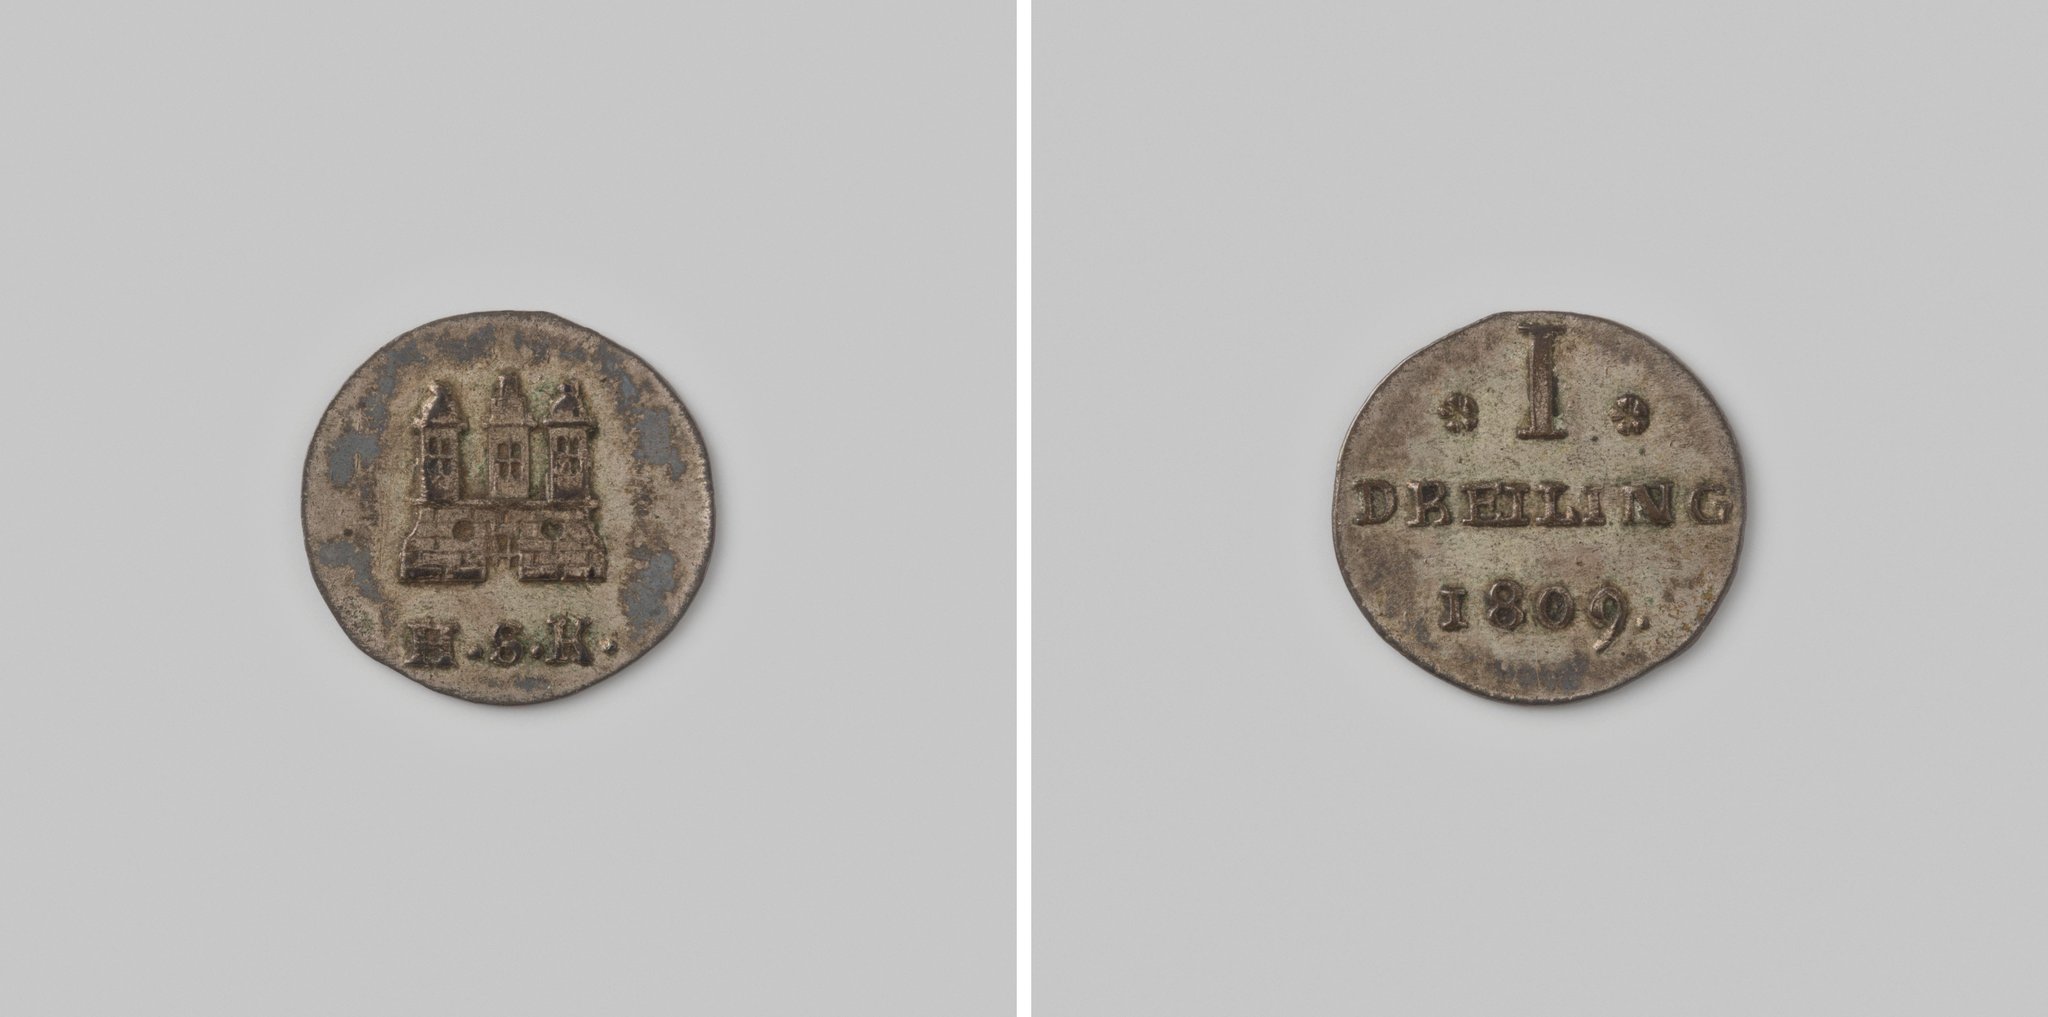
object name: coin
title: Dreiling uit de vrije hansestad Hamburg, 1809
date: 1809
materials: silver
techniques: striking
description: Zilveren munt. Voorzijde: wapen van de stad. Keerzijde: waarde-aanduiding in twee regels, waaronder jaartal. Gladde rand.